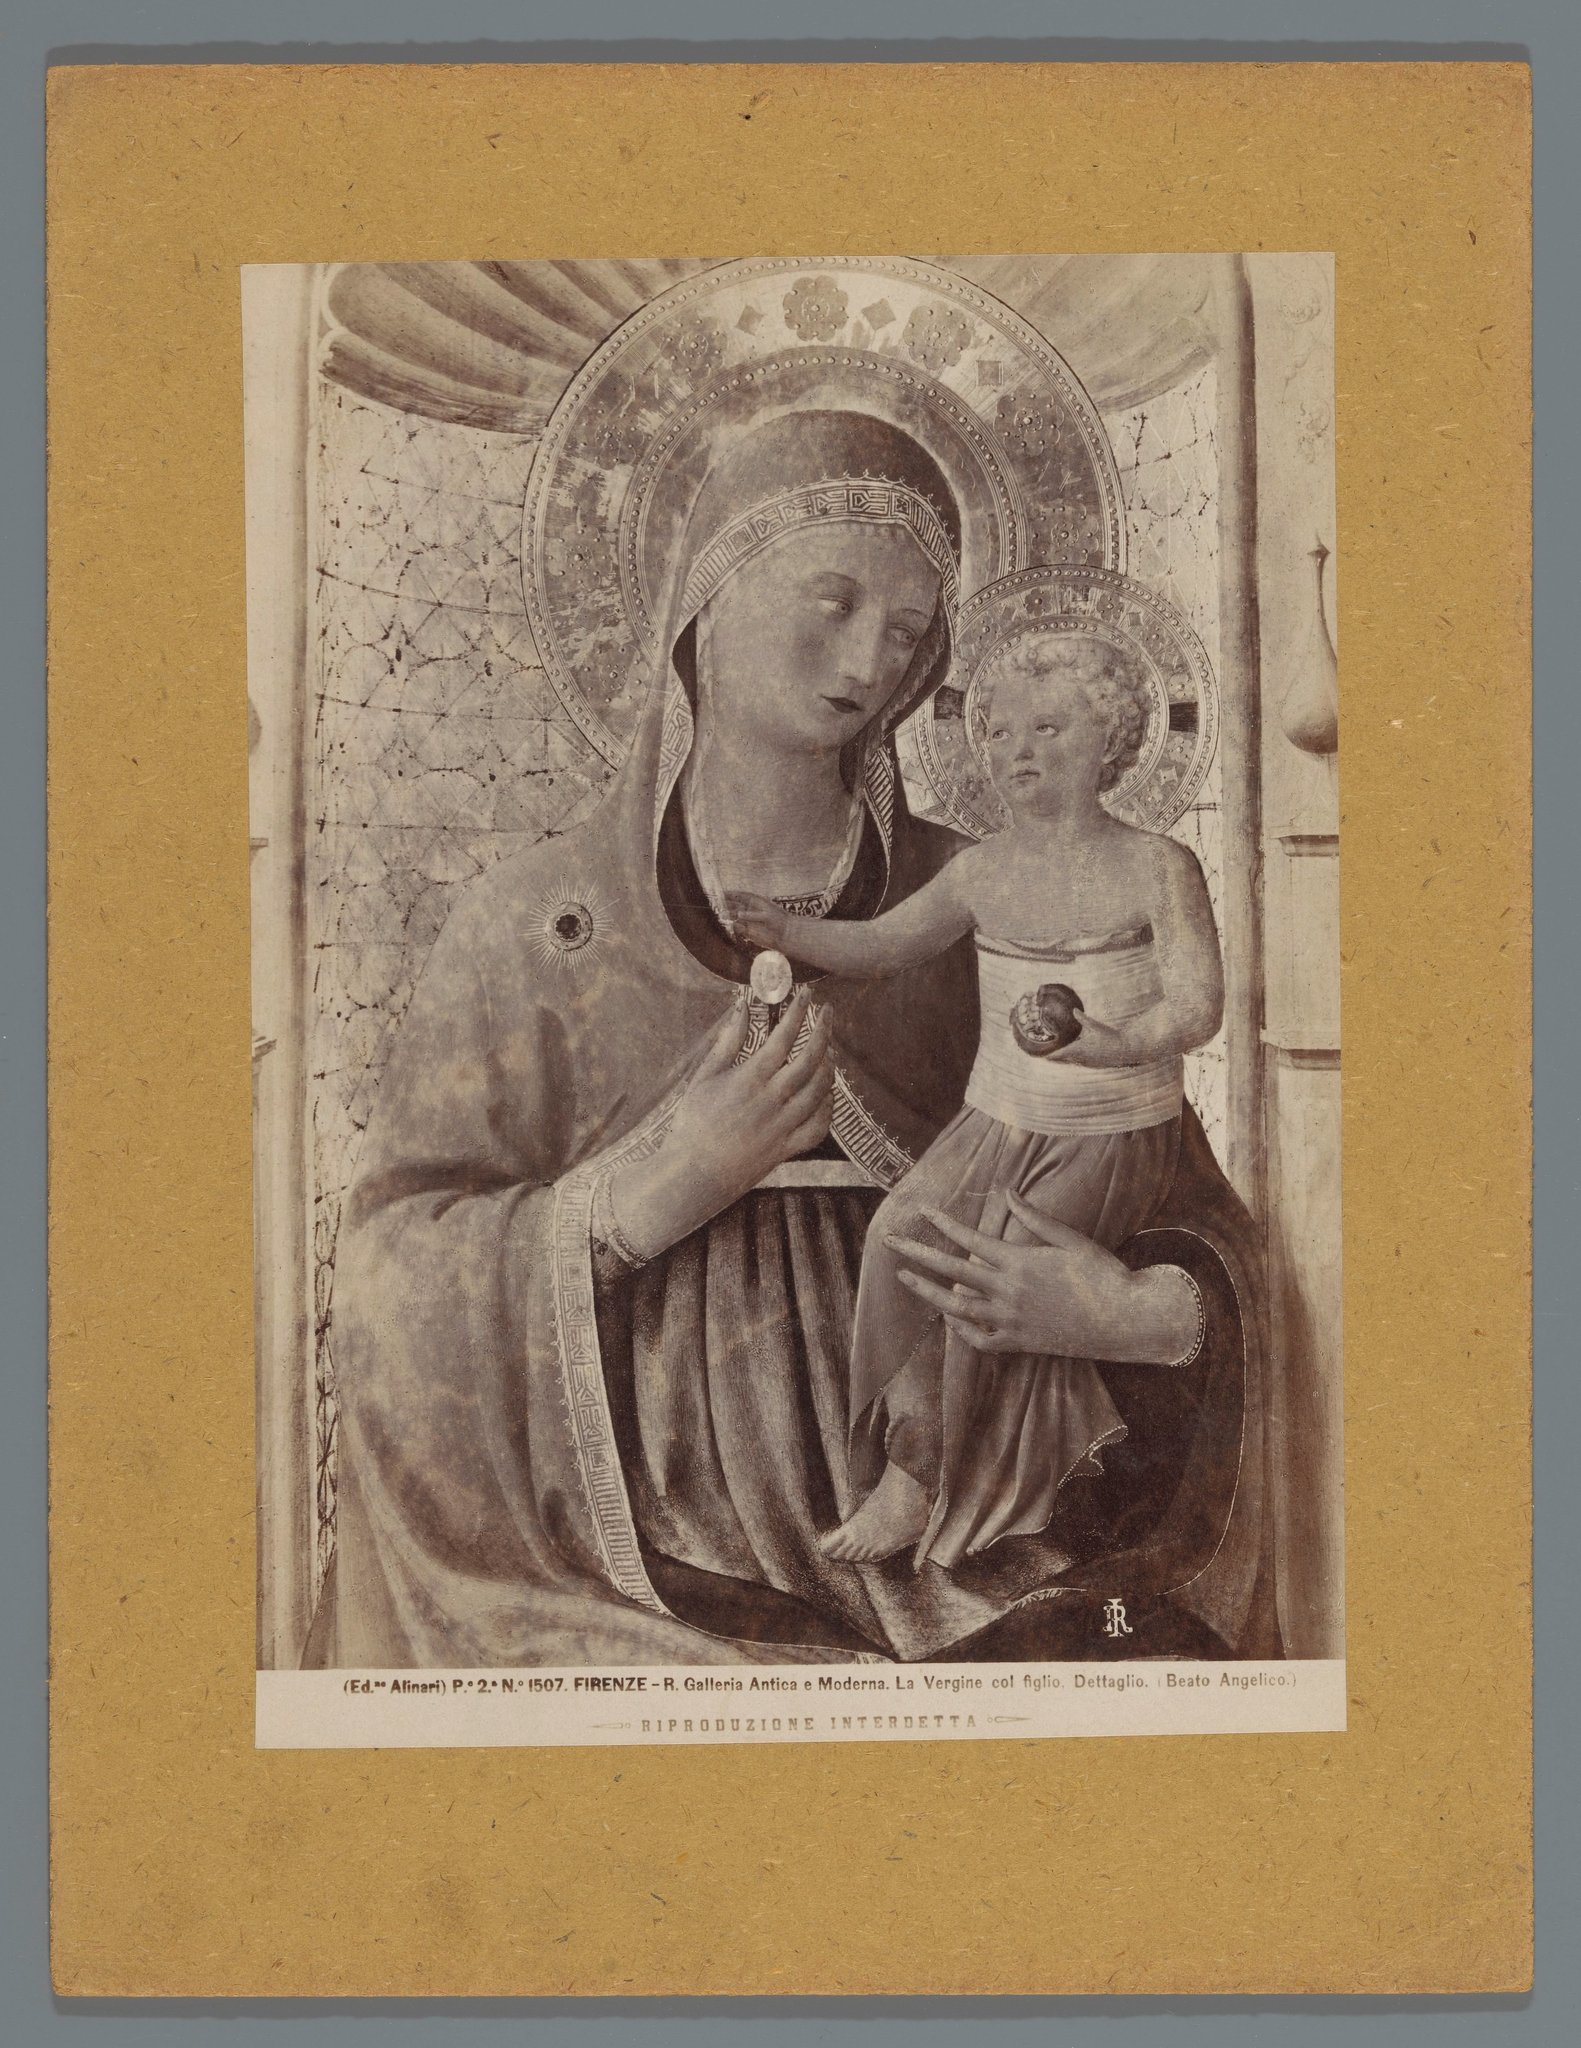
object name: photograph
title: FIRENZE - R. Galleria Antica e Moderna. La Vergine col figlio. Dettaglio.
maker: fra angelico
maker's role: painter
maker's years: 1400-1455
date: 1875-1900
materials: cardboard, photographic support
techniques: albumen print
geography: italy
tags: madonna: i.e. mary with the christ-child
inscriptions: number: ‘P.e 2.a N.o 1507.’, inscription:, collector's mark: Lugt 3937